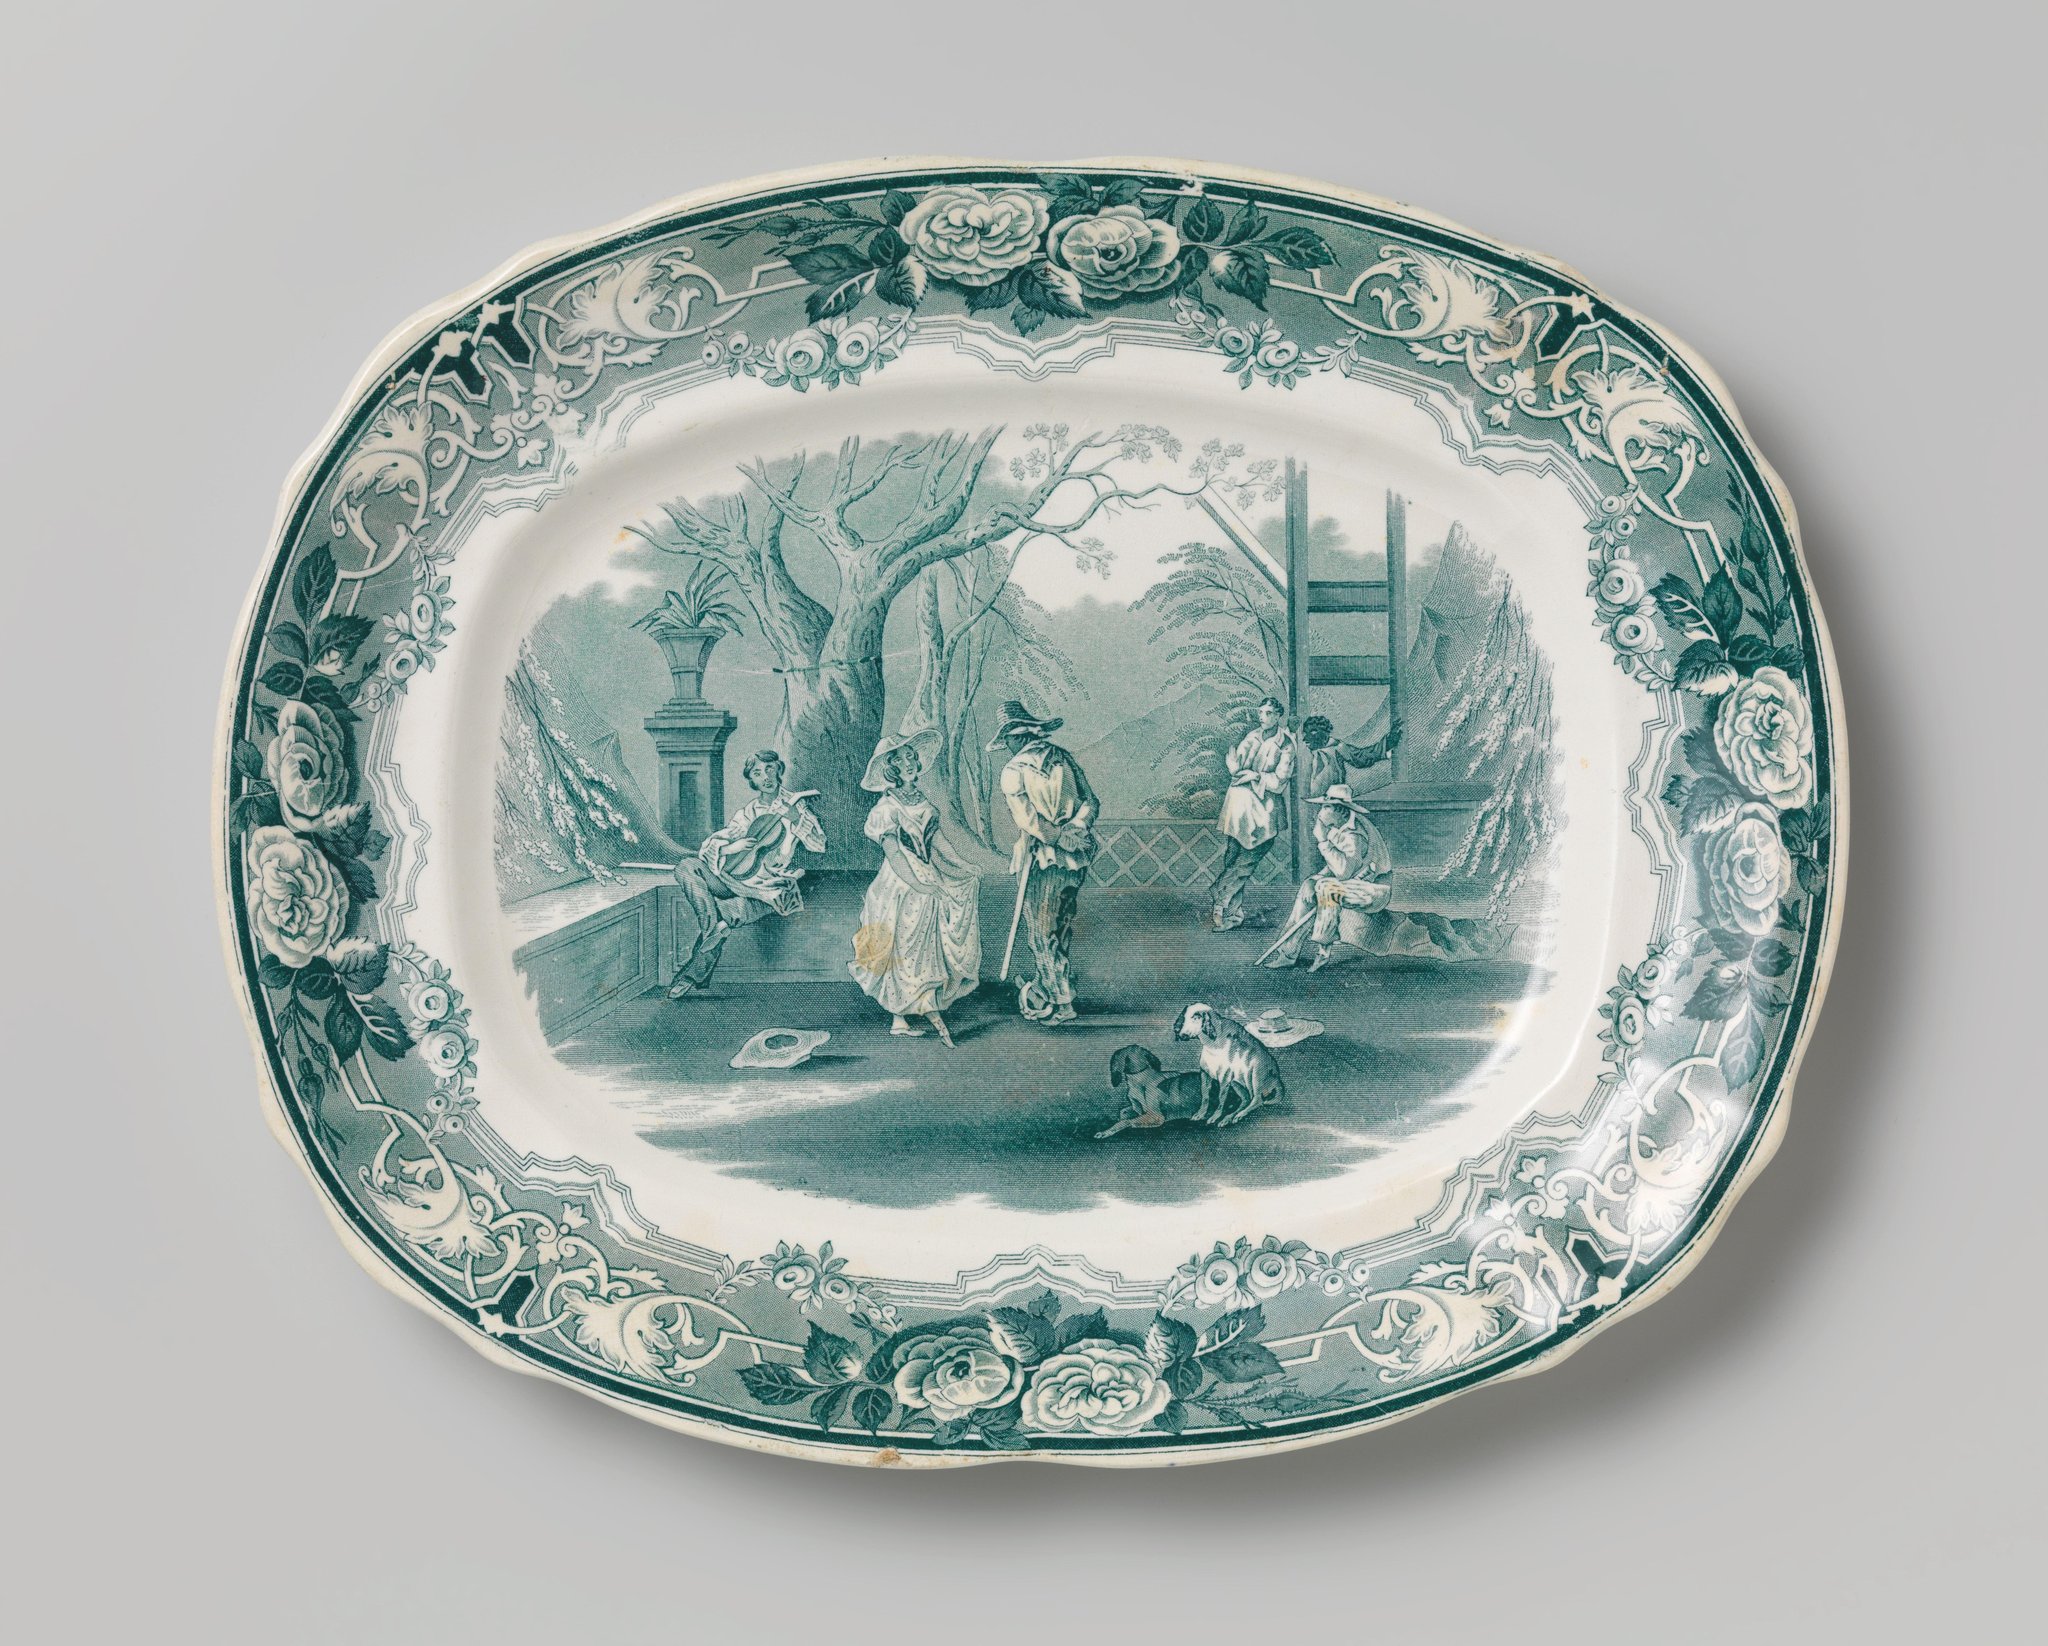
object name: platter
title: Schotel, oblong, met op het plat een voorstelling van dansers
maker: petrus regout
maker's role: plateelbakker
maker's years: 1801-1879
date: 1850-1875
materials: creamware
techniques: transfer decoration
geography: maastricht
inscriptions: mark: ‘Staffordshire knot // PR // PRIZE MEDAL // 1851 // DANCERS’, check stamp: ‘P. REGOUT // 14 // Maastricht’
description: Schotel van aardewerk, oblong, met groen transferdecor. Op het plat met dansers, begeleid door een gitaarspeler en enkele toeschouwers. De rand is gedecoreerd met bloemen.